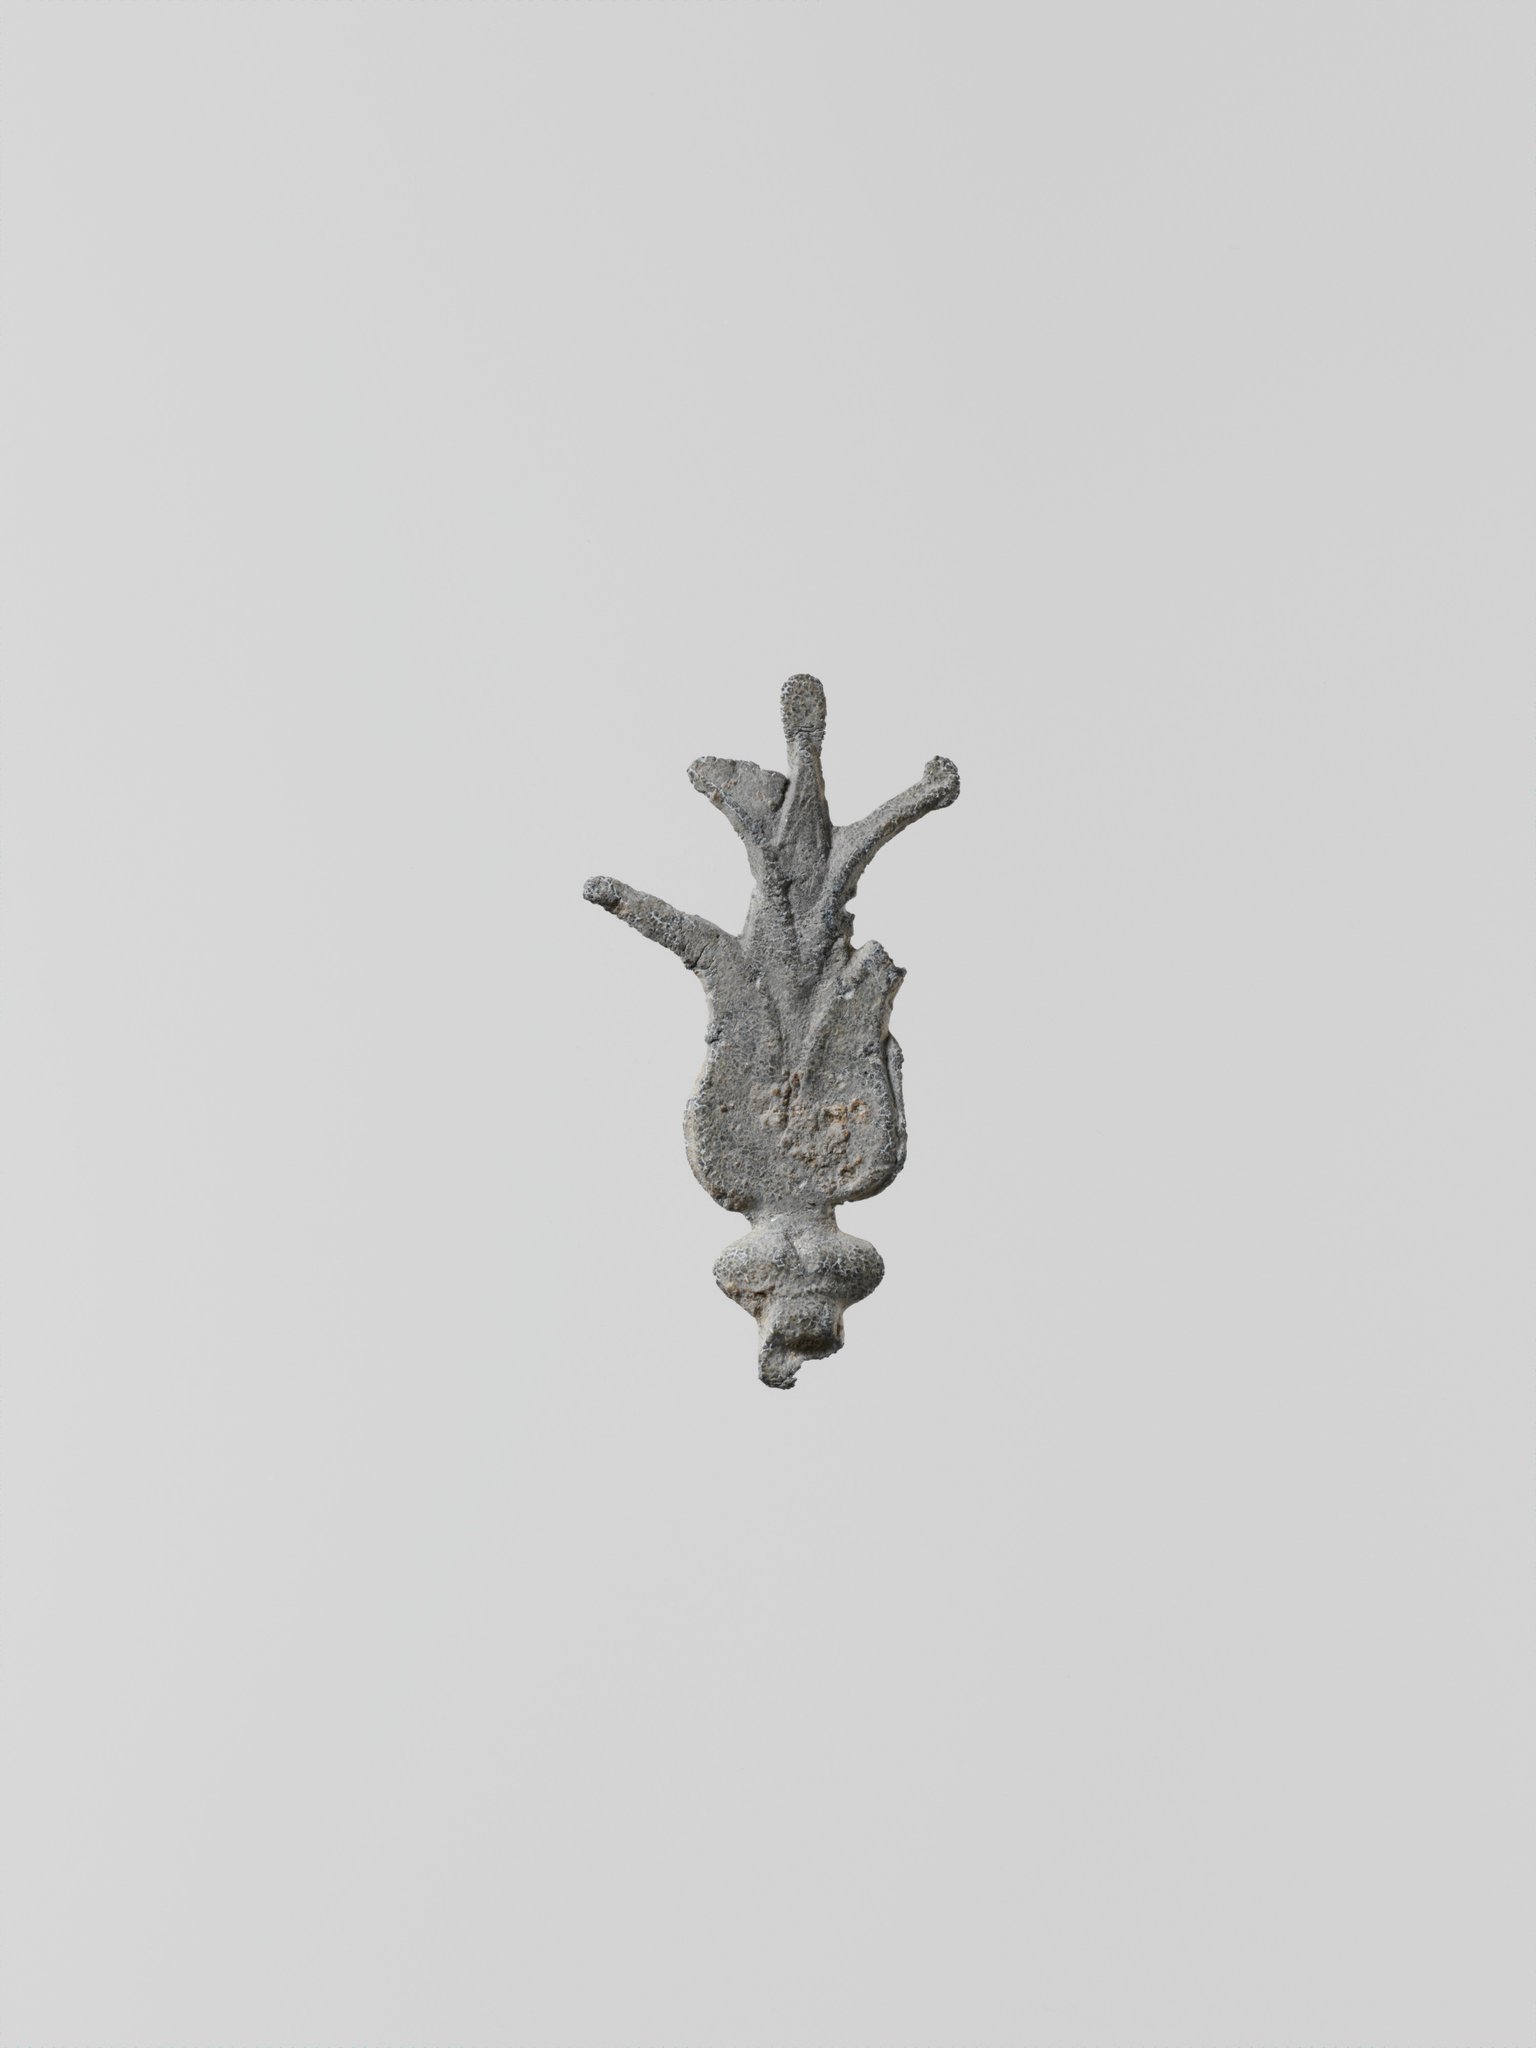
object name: ornament, 4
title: Lead ornament in the form of a bud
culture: greek, laconian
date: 600-401 BCE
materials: lead